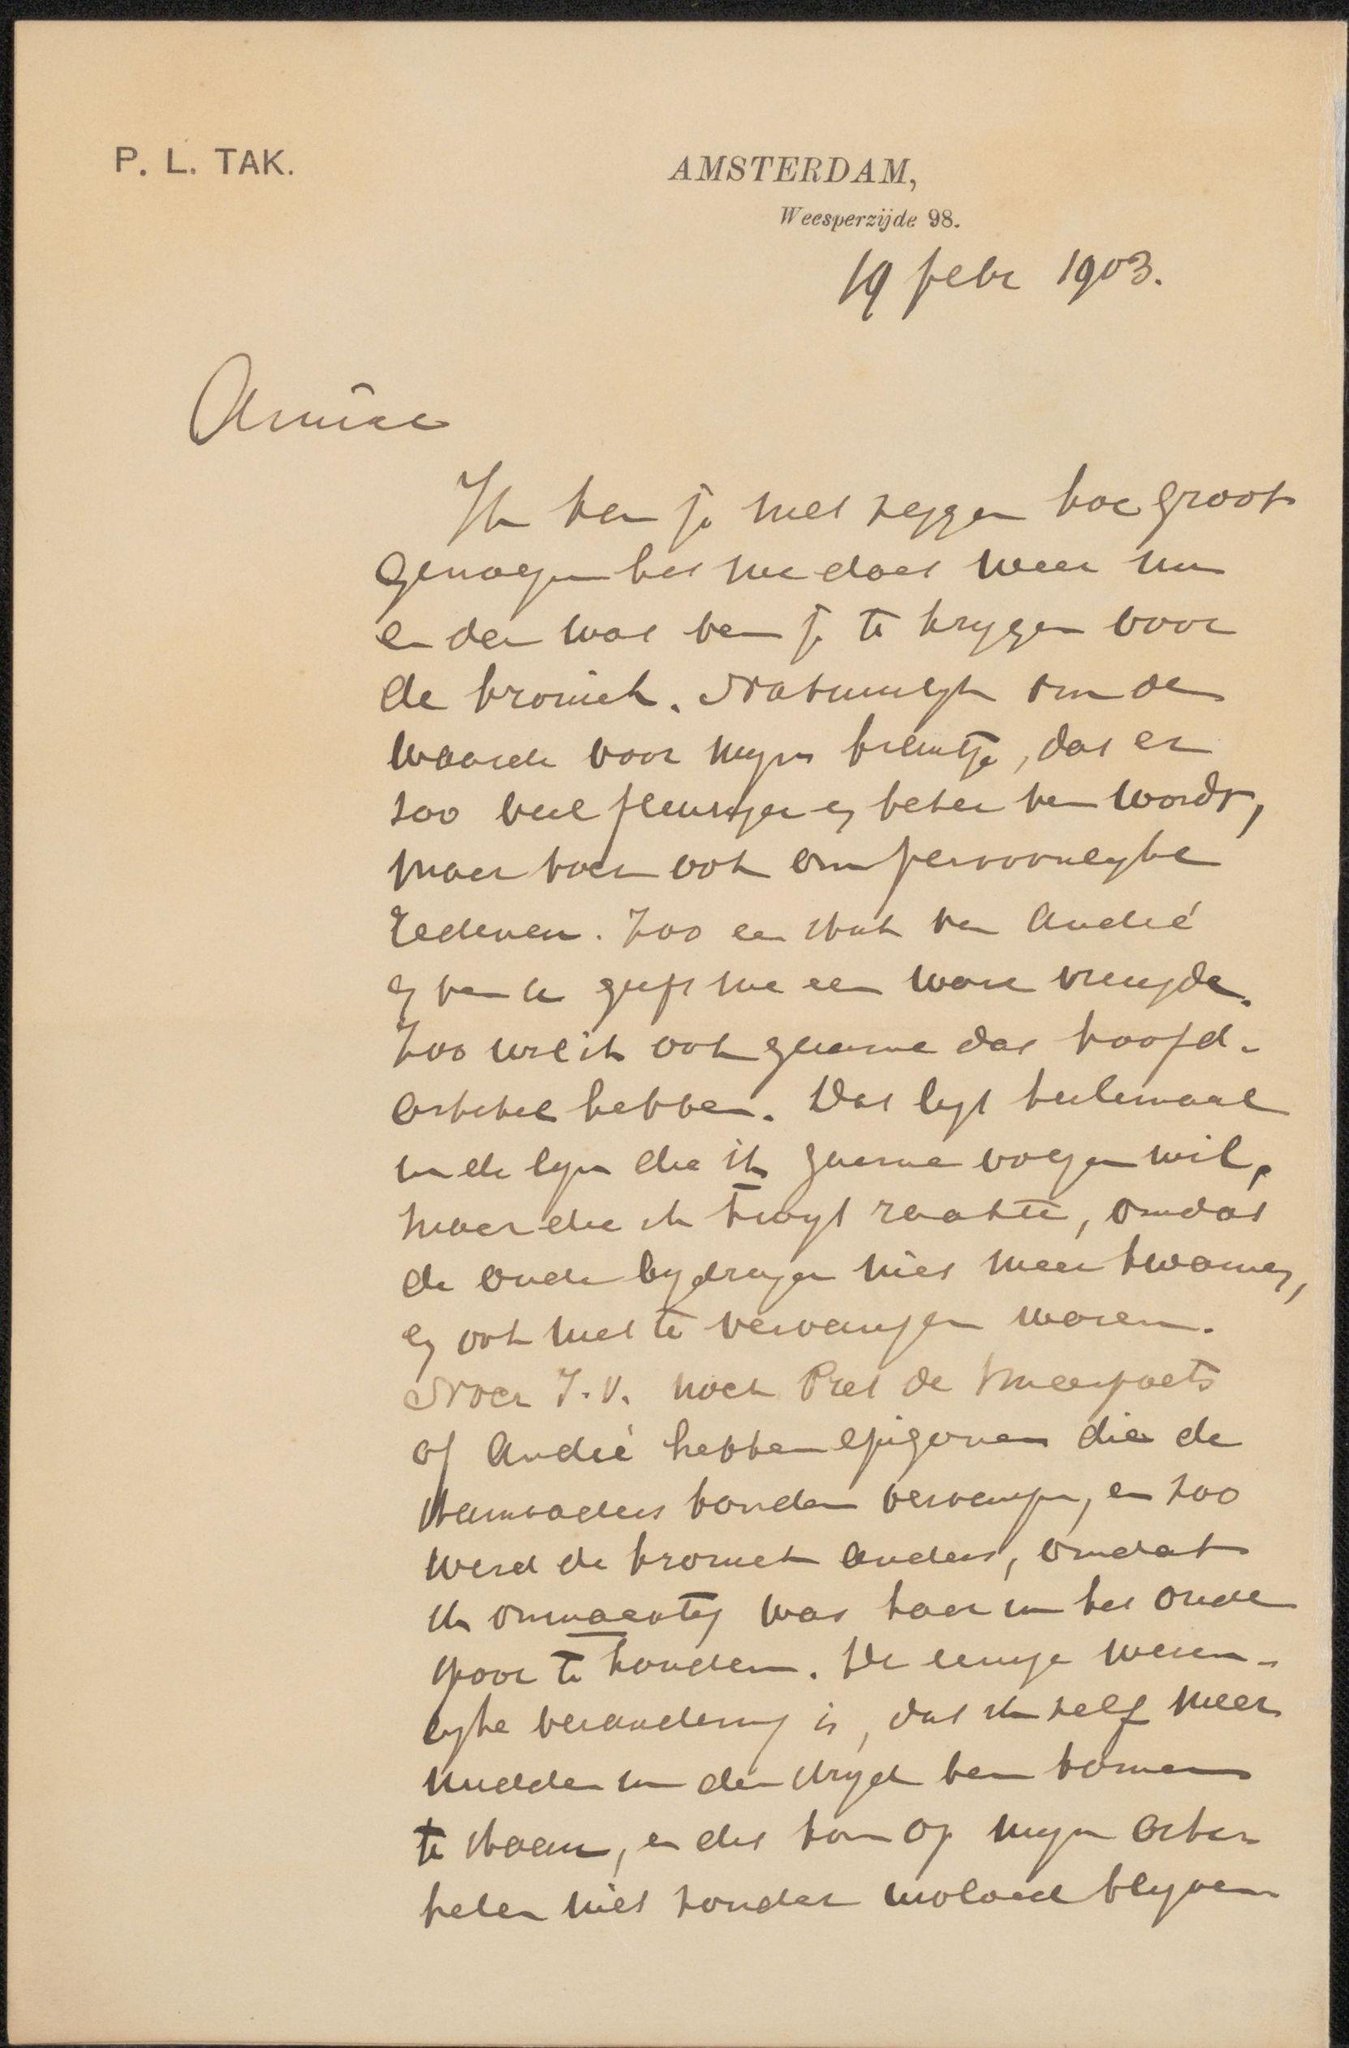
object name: letter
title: Brief aan Jan Veth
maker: pieter lodewijk tak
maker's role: politician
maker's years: 1848-1907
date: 1903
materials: ink, paper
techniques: pen, printing, writing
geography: amsterdam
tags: dordrecht, painter, print maker, draughtsman, designer, jan veth, andré jolles, augsburg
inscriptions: watermark, collector's mark: ‘RPK’